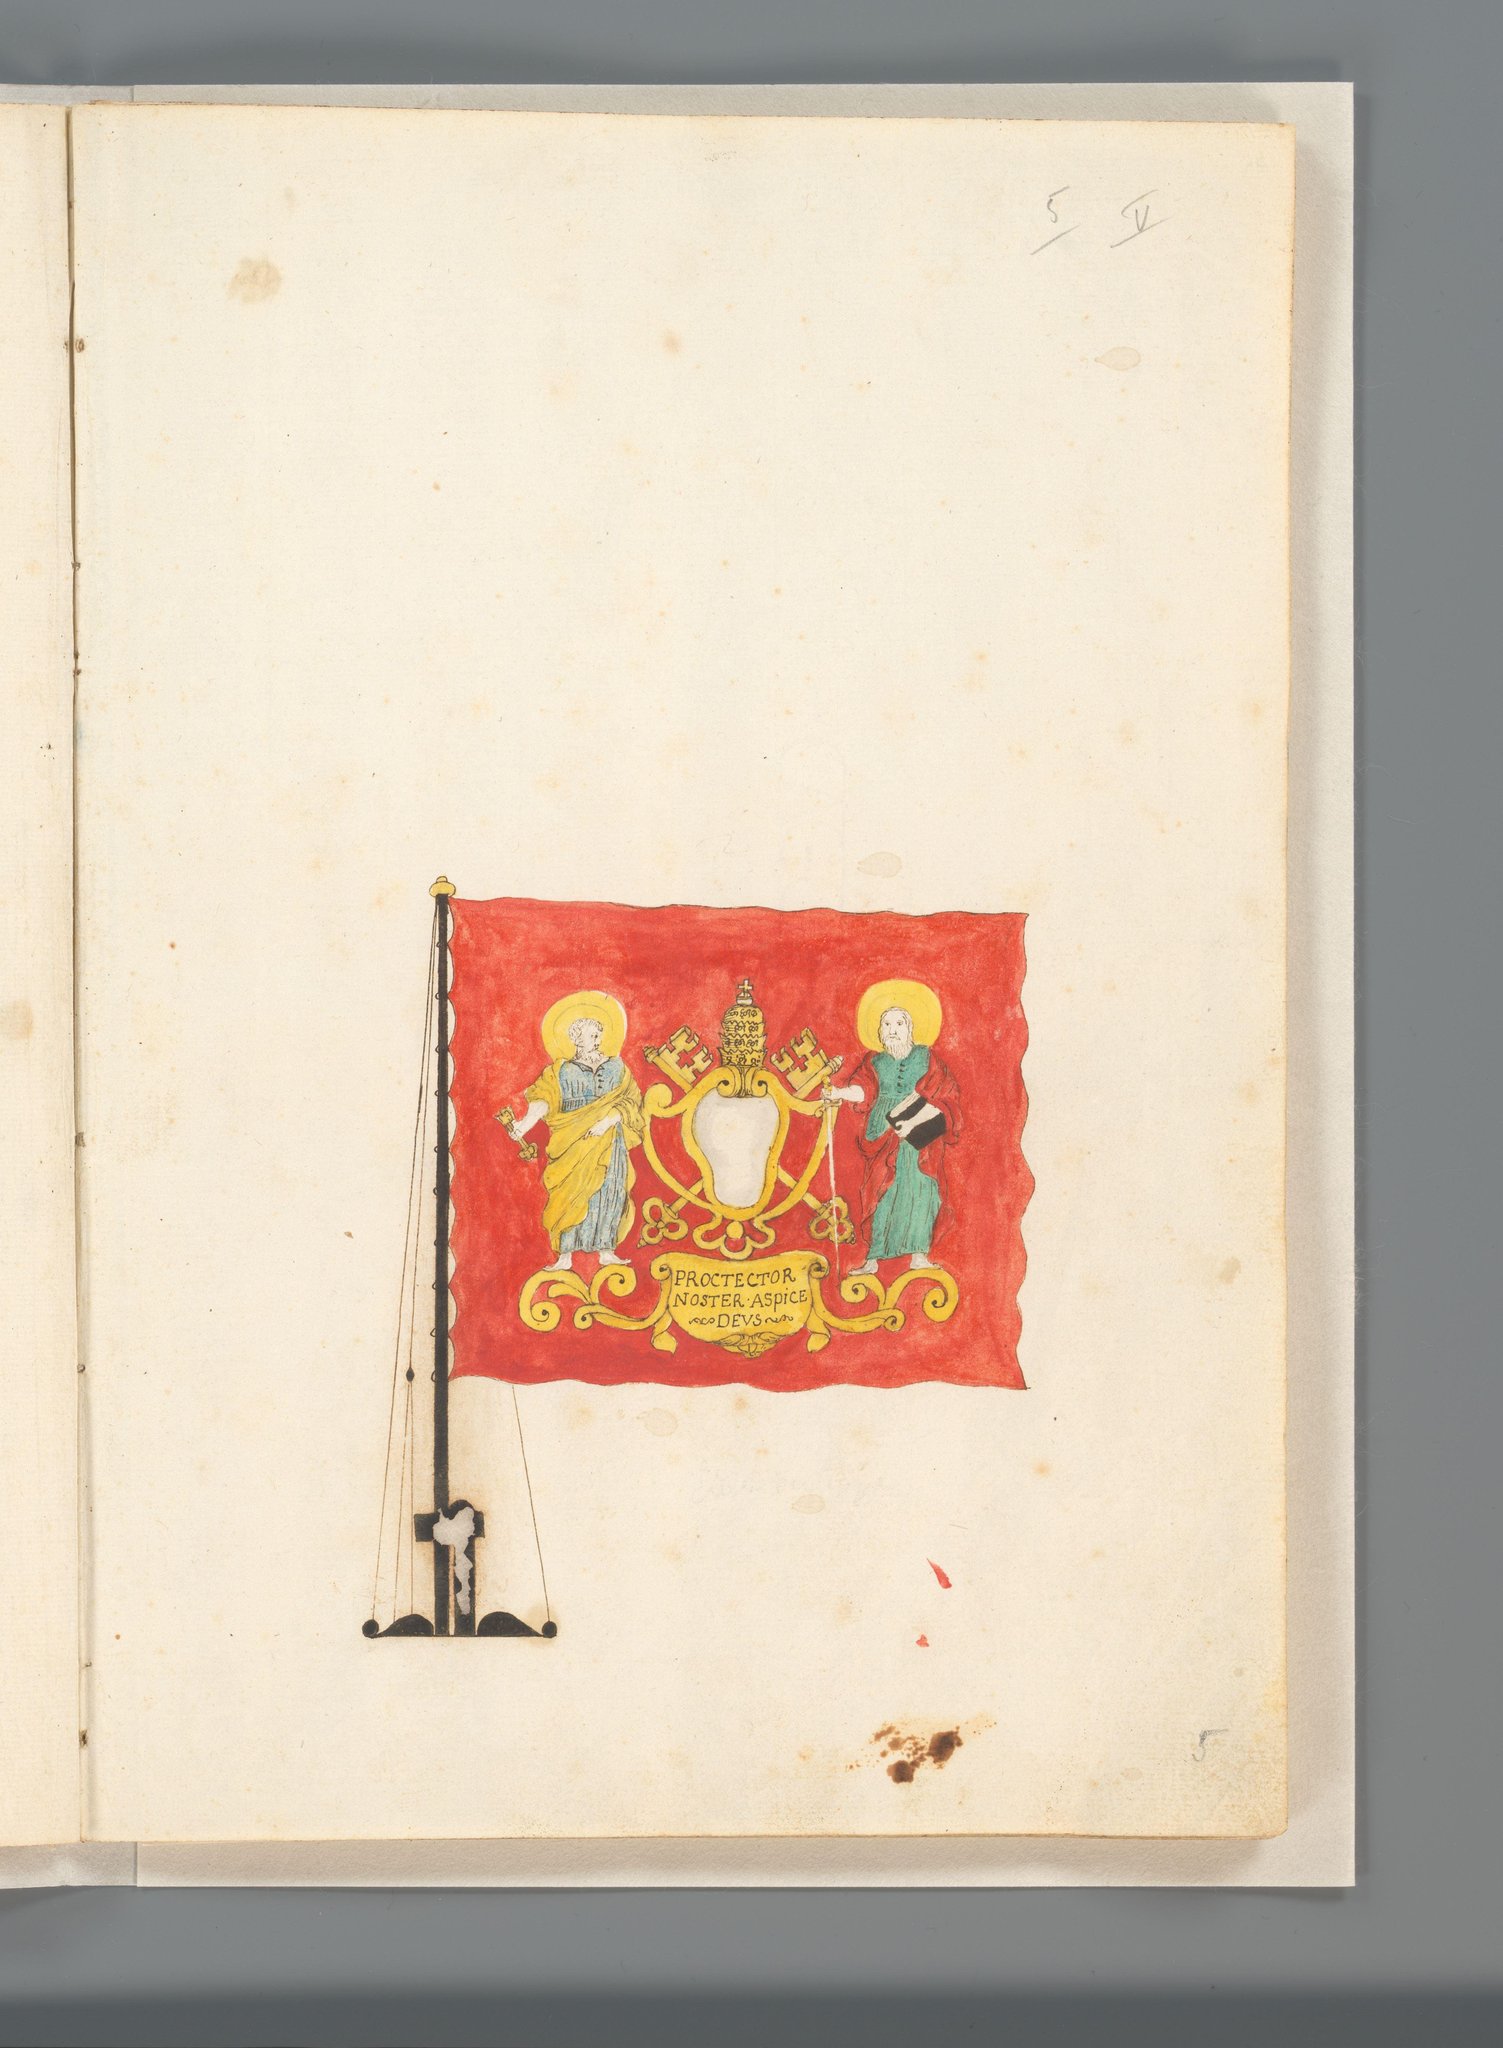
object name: drawing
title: Pauselijke vlag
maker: Anonymous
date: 1667-1670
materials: ink, paper, watercolor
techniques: brush, pen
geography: france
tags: flag, colours (as symbol of the state, etc.)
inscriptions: number: ‘5 / V / 5’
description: Vlag van de paus met op een rood veld een blanco wapenschild geflankeerd door Petrus en Paulus en onder de pauselijke tiara. Daaronder het pauselijk devies 'Protector Noster Aspice Deus'. Vlag op vlaggensteng en mastvoet. Afgebeeld op folio 3r. Onderdeel van een vlaggenboek met vlaggen uit Europa, Noord-Afrika, Nabije en Verre Oosten.